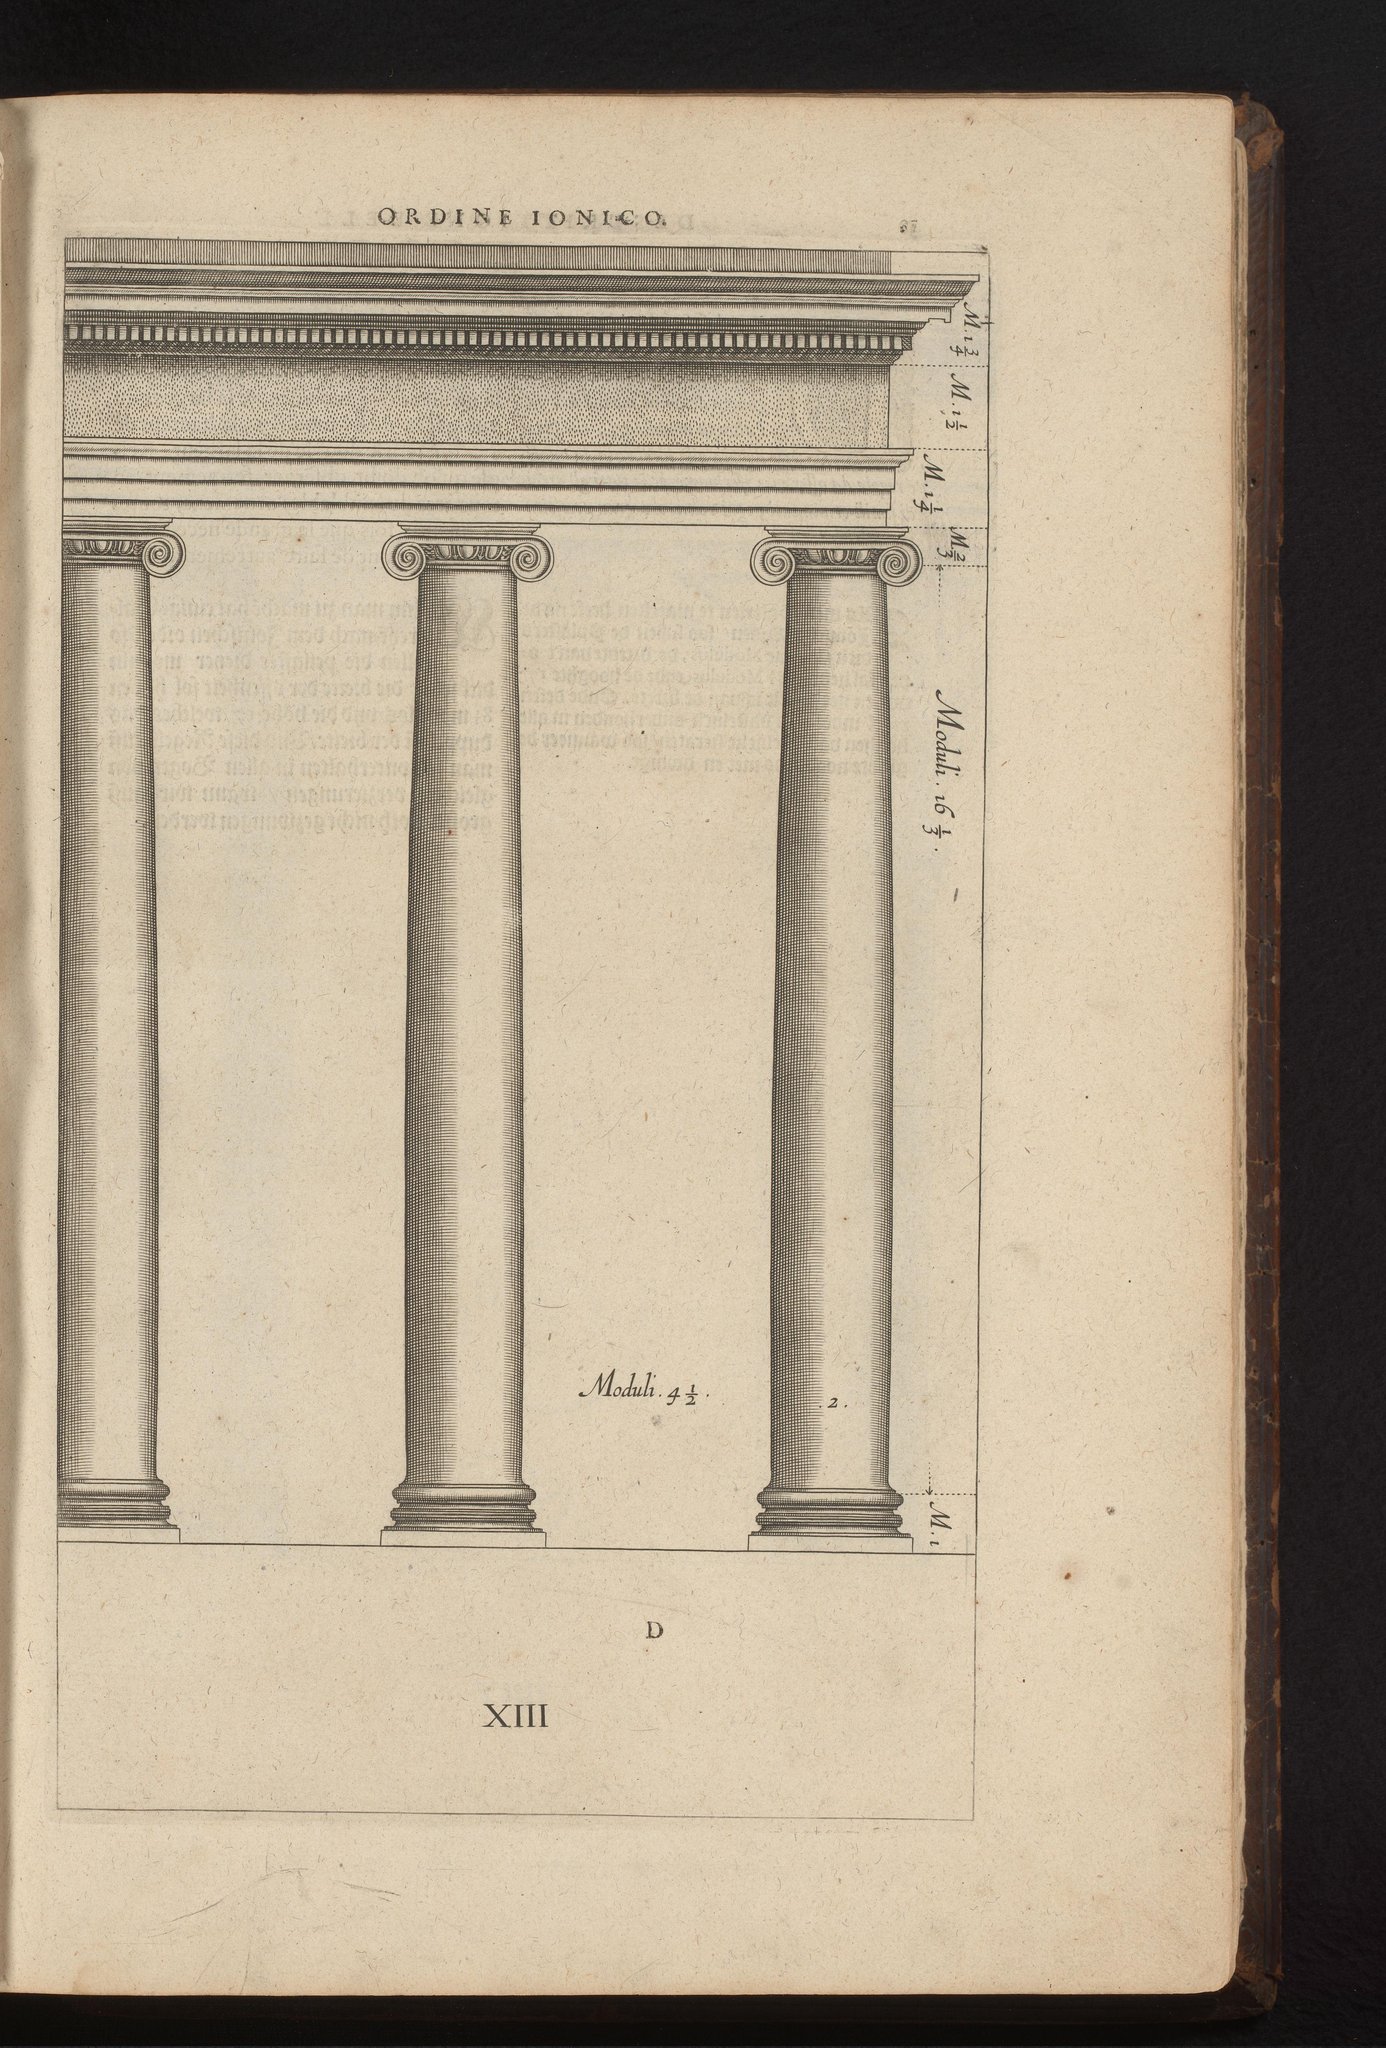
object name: book illustration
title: Ionische zuilen en hoofdgestel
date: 1640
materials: paper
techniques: engraving, letterpress printing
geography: amsterdam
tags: orders, order-books ~ architecture, ionic order ~ architecture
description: Prent uit: Vignola, Giacomo Barozzi da. Regola delli cinque ordini d'architettura (...). Amsterdam: Johannes Willemszoon en Cornelis Blaeu, 1640, p. 37.